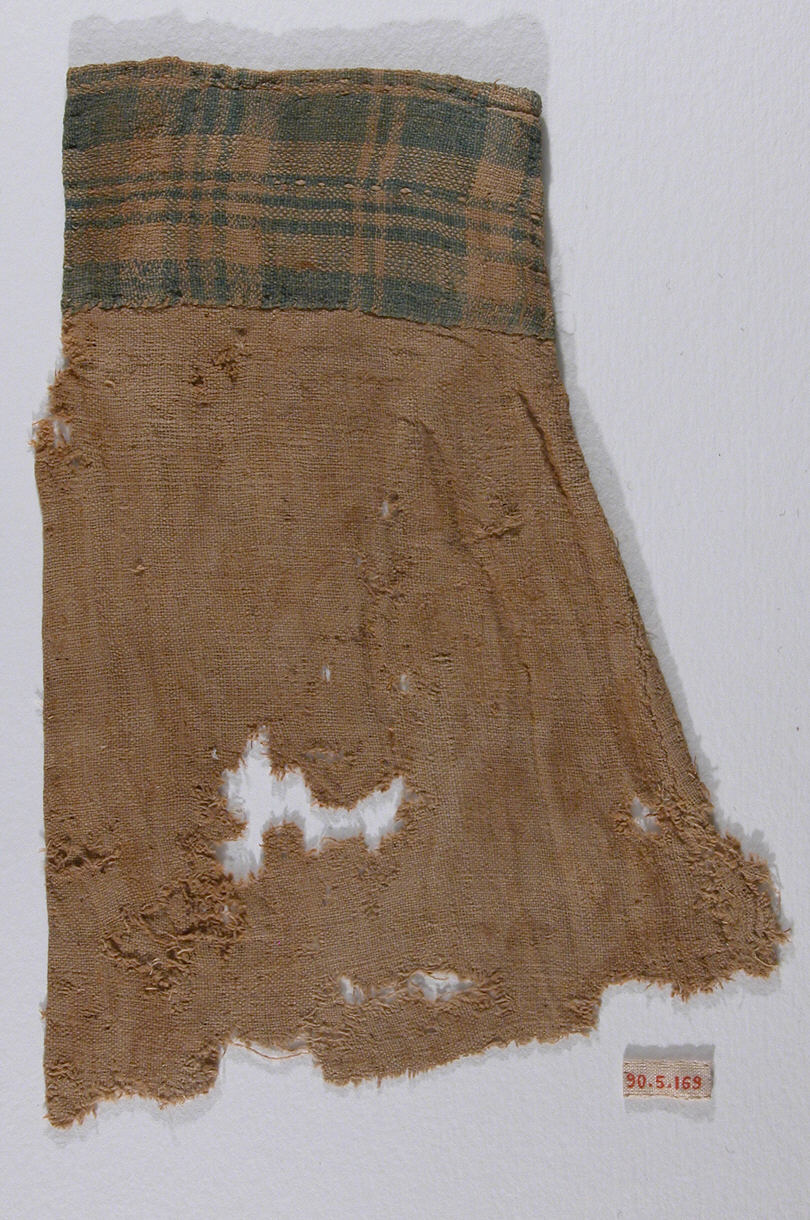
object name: textile fragment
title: Sleeve Fragment with Plaid Cuff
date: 301-900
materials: linen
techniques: weave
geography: egypt